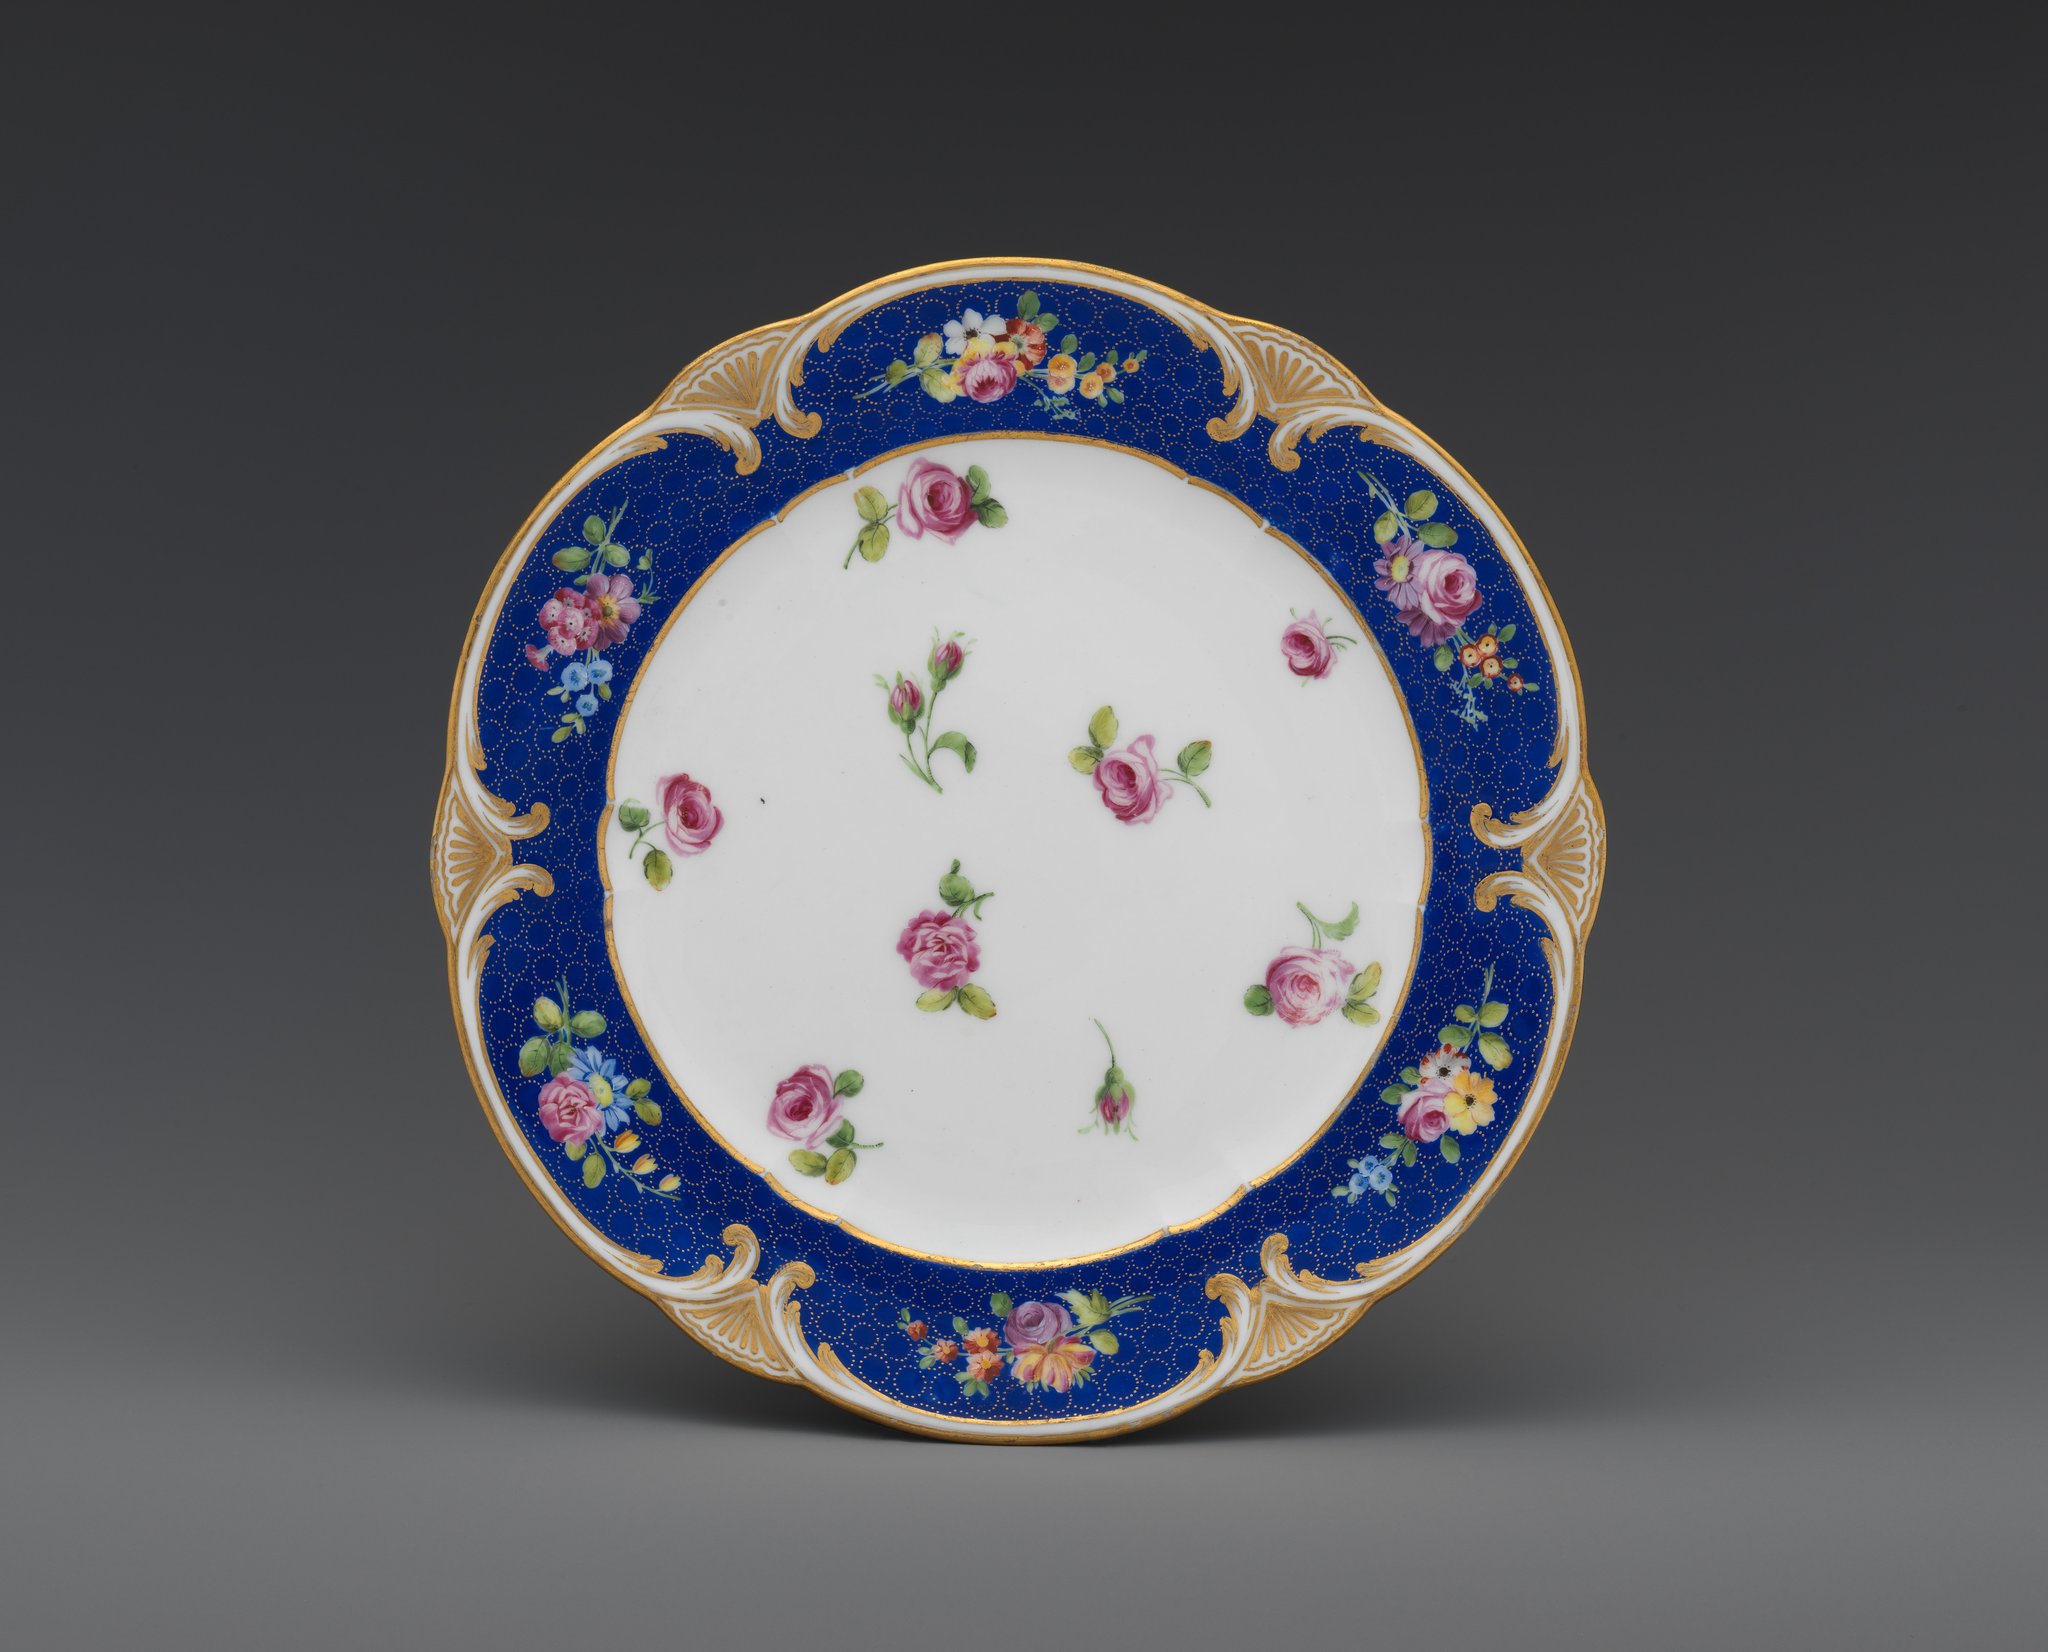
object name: plate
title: Plate (assiette à palmes)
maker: sèvres manufactory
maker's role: manufactory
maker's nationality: french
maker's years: 1740-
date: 1771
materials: soft paste porcelain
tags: roses